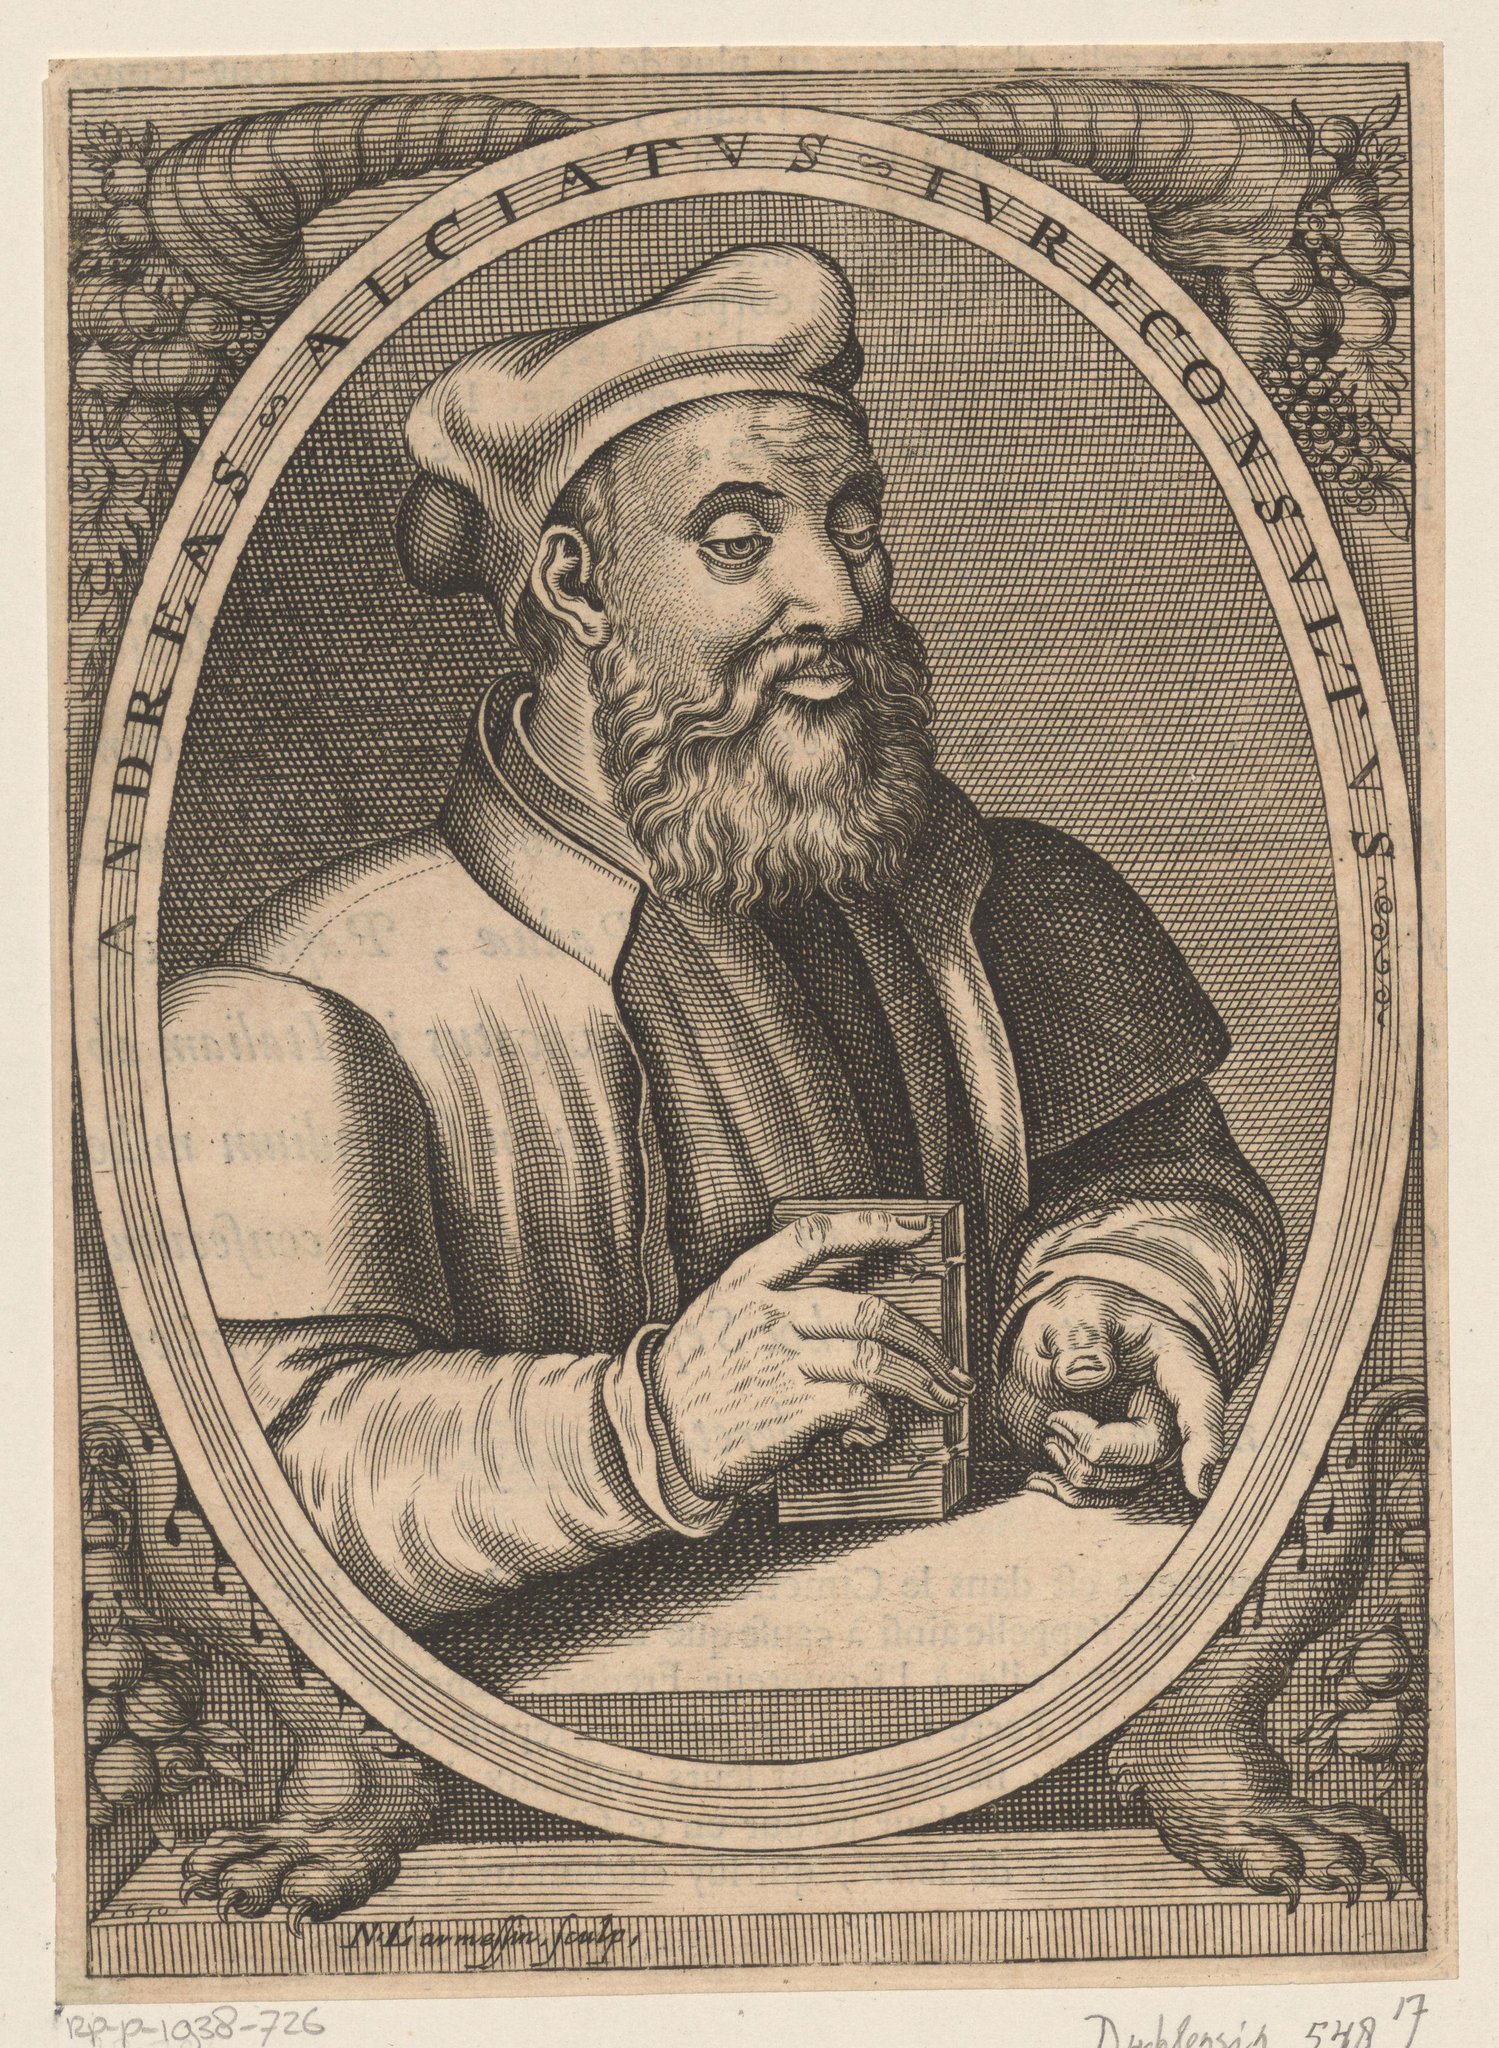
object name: book illustration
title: Portret van Giovanni Andrea Alciato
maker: nicolas de larmessin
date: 1630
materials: paper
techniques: engraving, letterpress printing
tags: andrea alciato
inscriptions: collector's mark: Lugt 2228